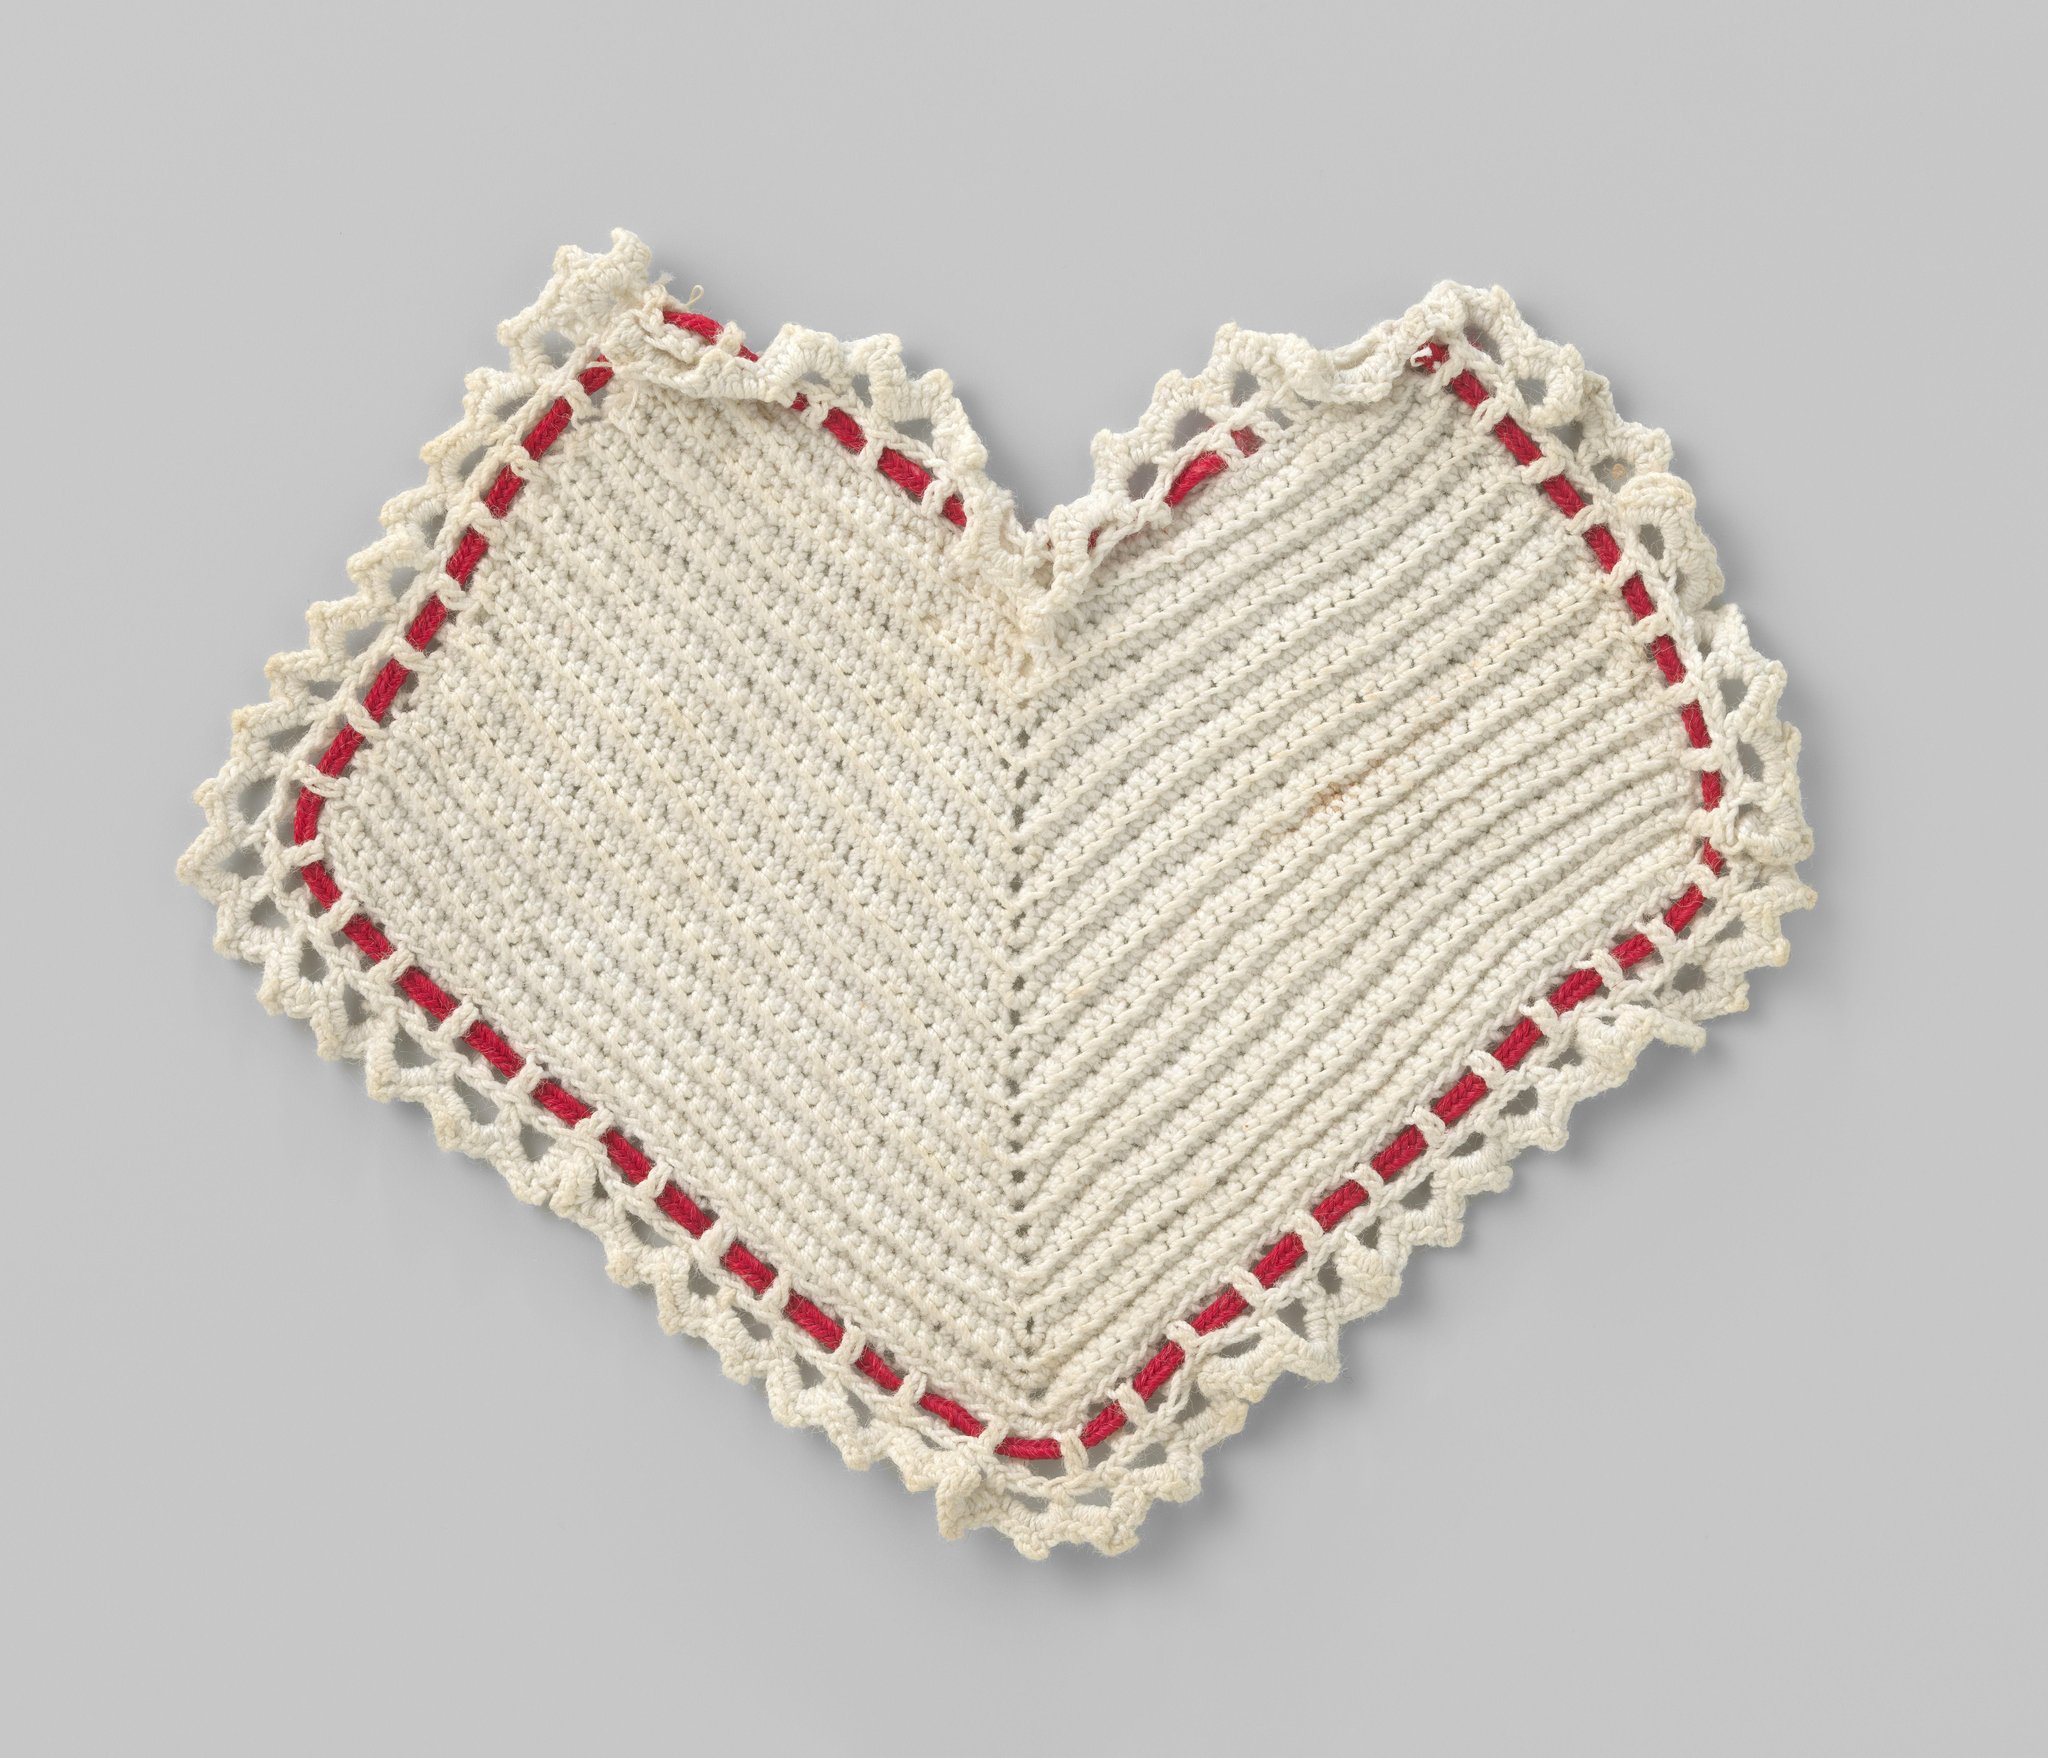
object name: apron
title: Wit gebreid schort met rode veter voor pop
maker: Anonymous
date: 1850-1920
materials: textile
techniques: knitting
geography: netherlands